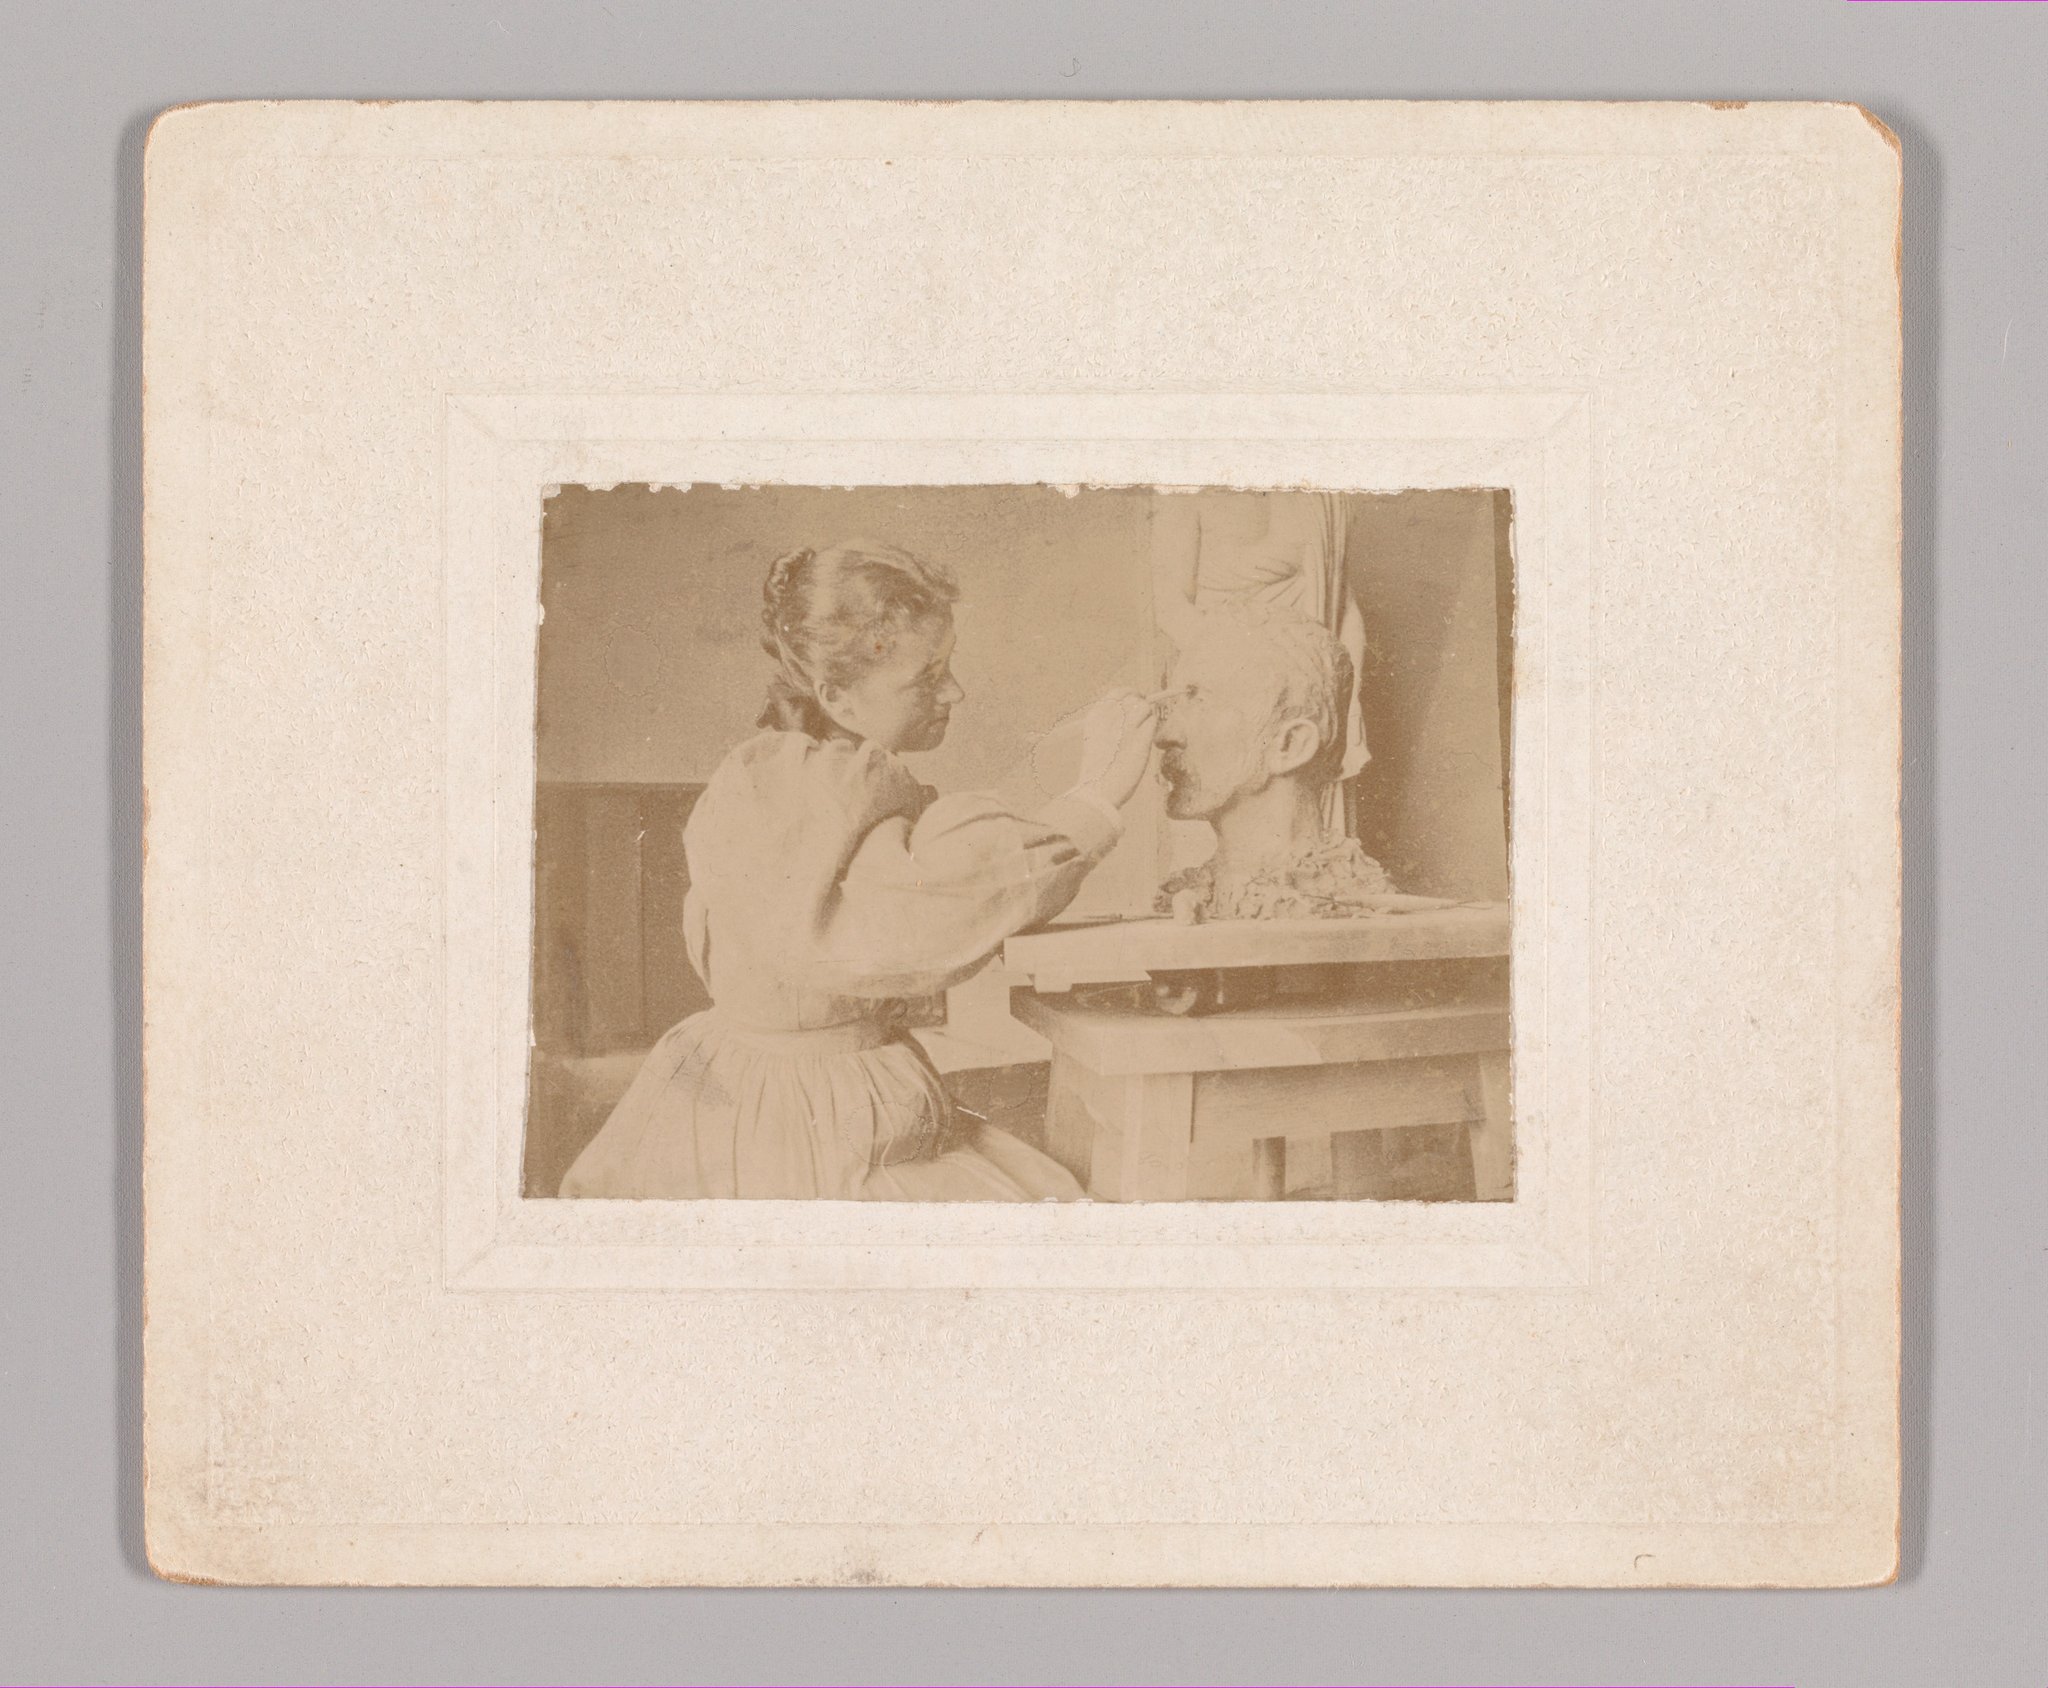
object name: carte de visite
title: [Grace Lee Rinehart]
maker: Anonymous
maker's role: artist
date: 1860-1869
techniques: albumen silver print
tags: sculpture,portraits,women,artists